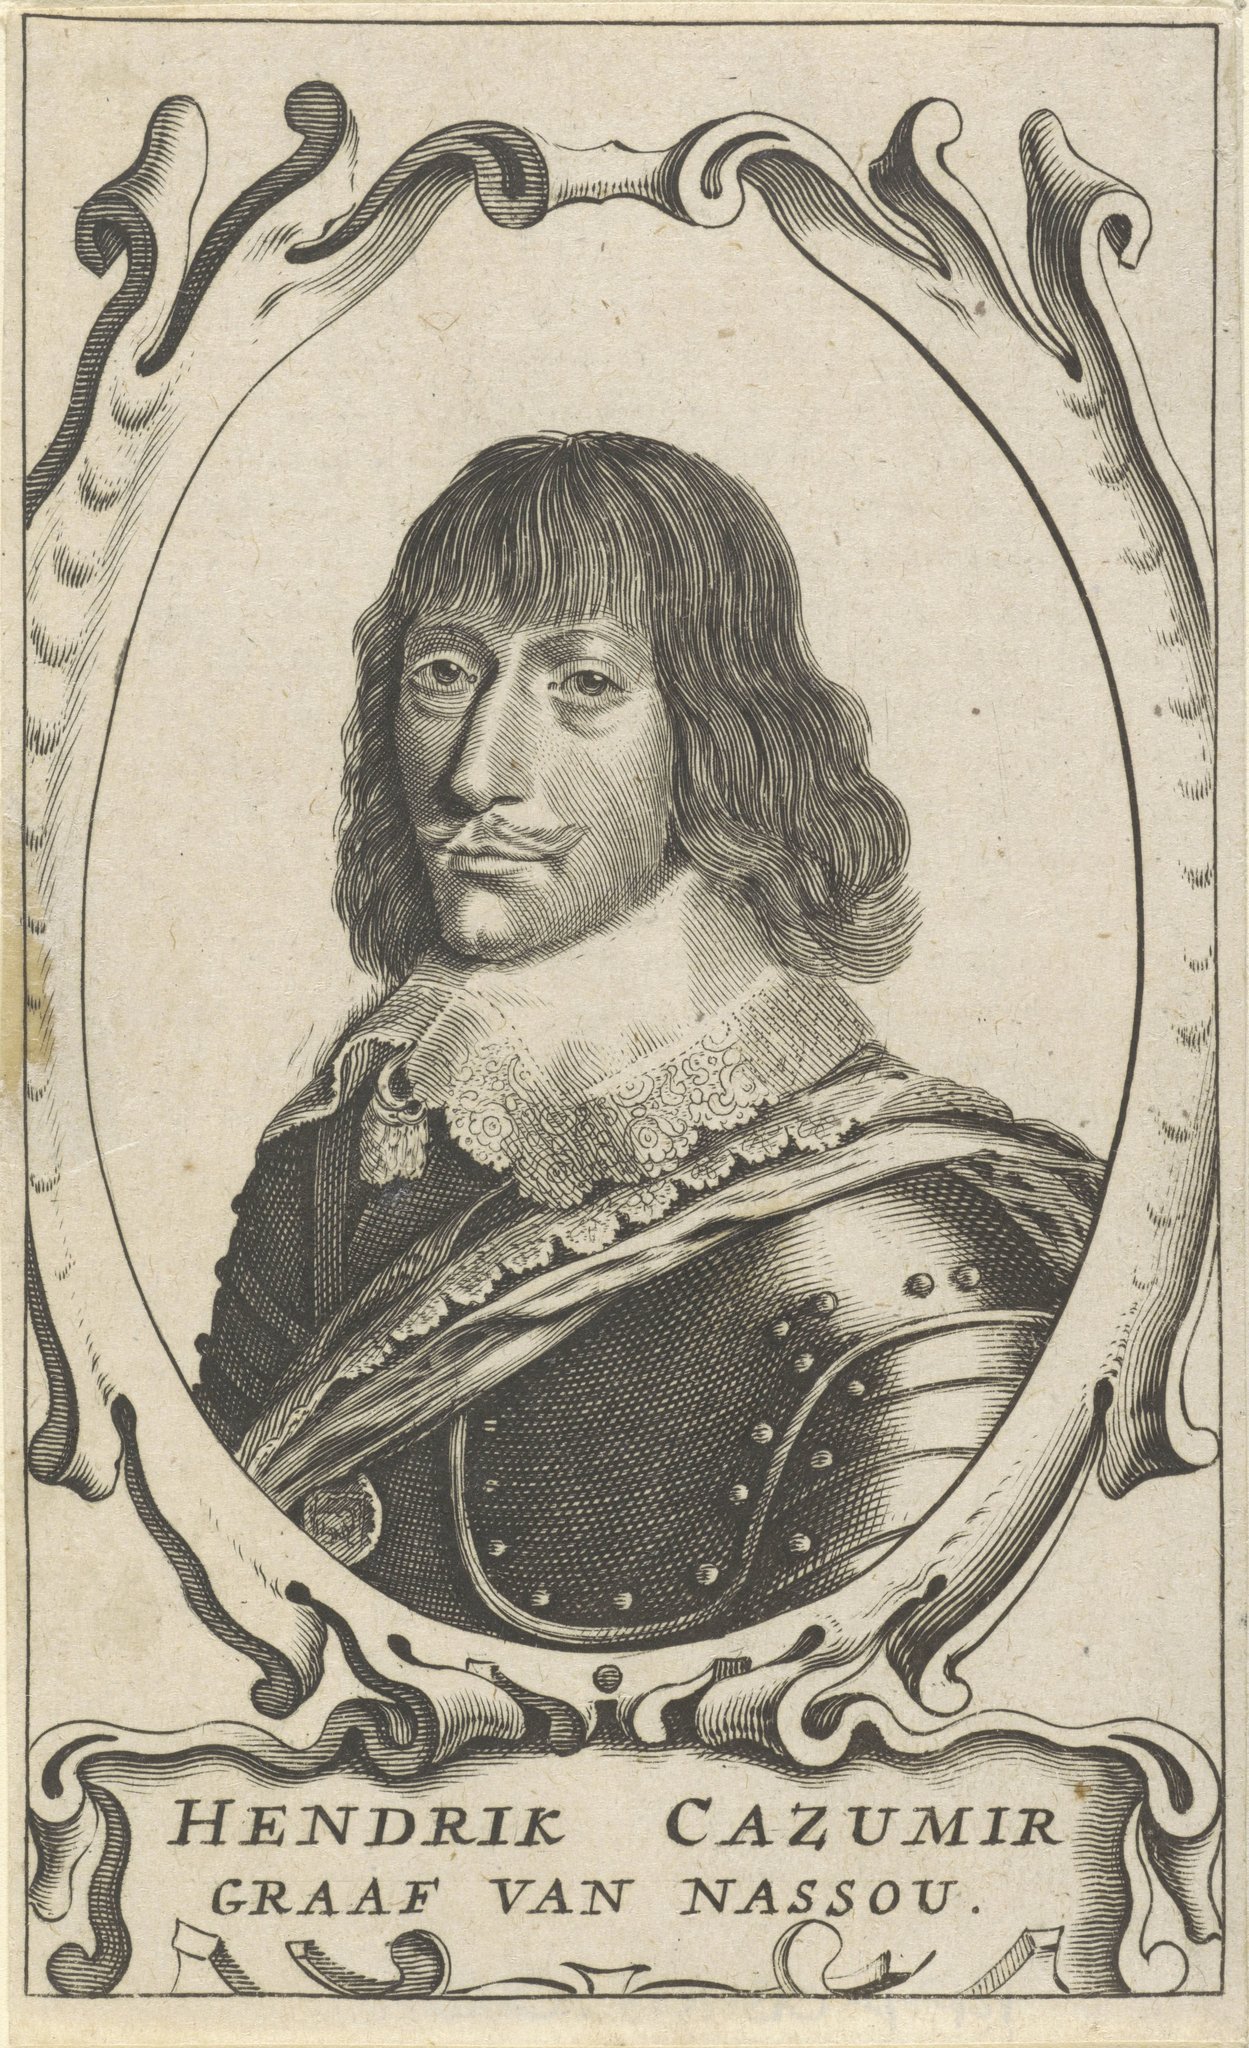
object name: print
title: Portret van Hendrik Casimir I, graaf van Nassau-Dietz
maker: Anonymous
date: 1630-1699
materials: paper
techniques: engraving, etching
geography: low countries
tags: arnhem, hendrik casimir i graaf van nassau-dietz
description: De hier vermelde titel verwijst naar de hoogst verkregen titel van de geportretteerde, niet per se naar de titel die de geportretteerde op deze voorstelling draagt.